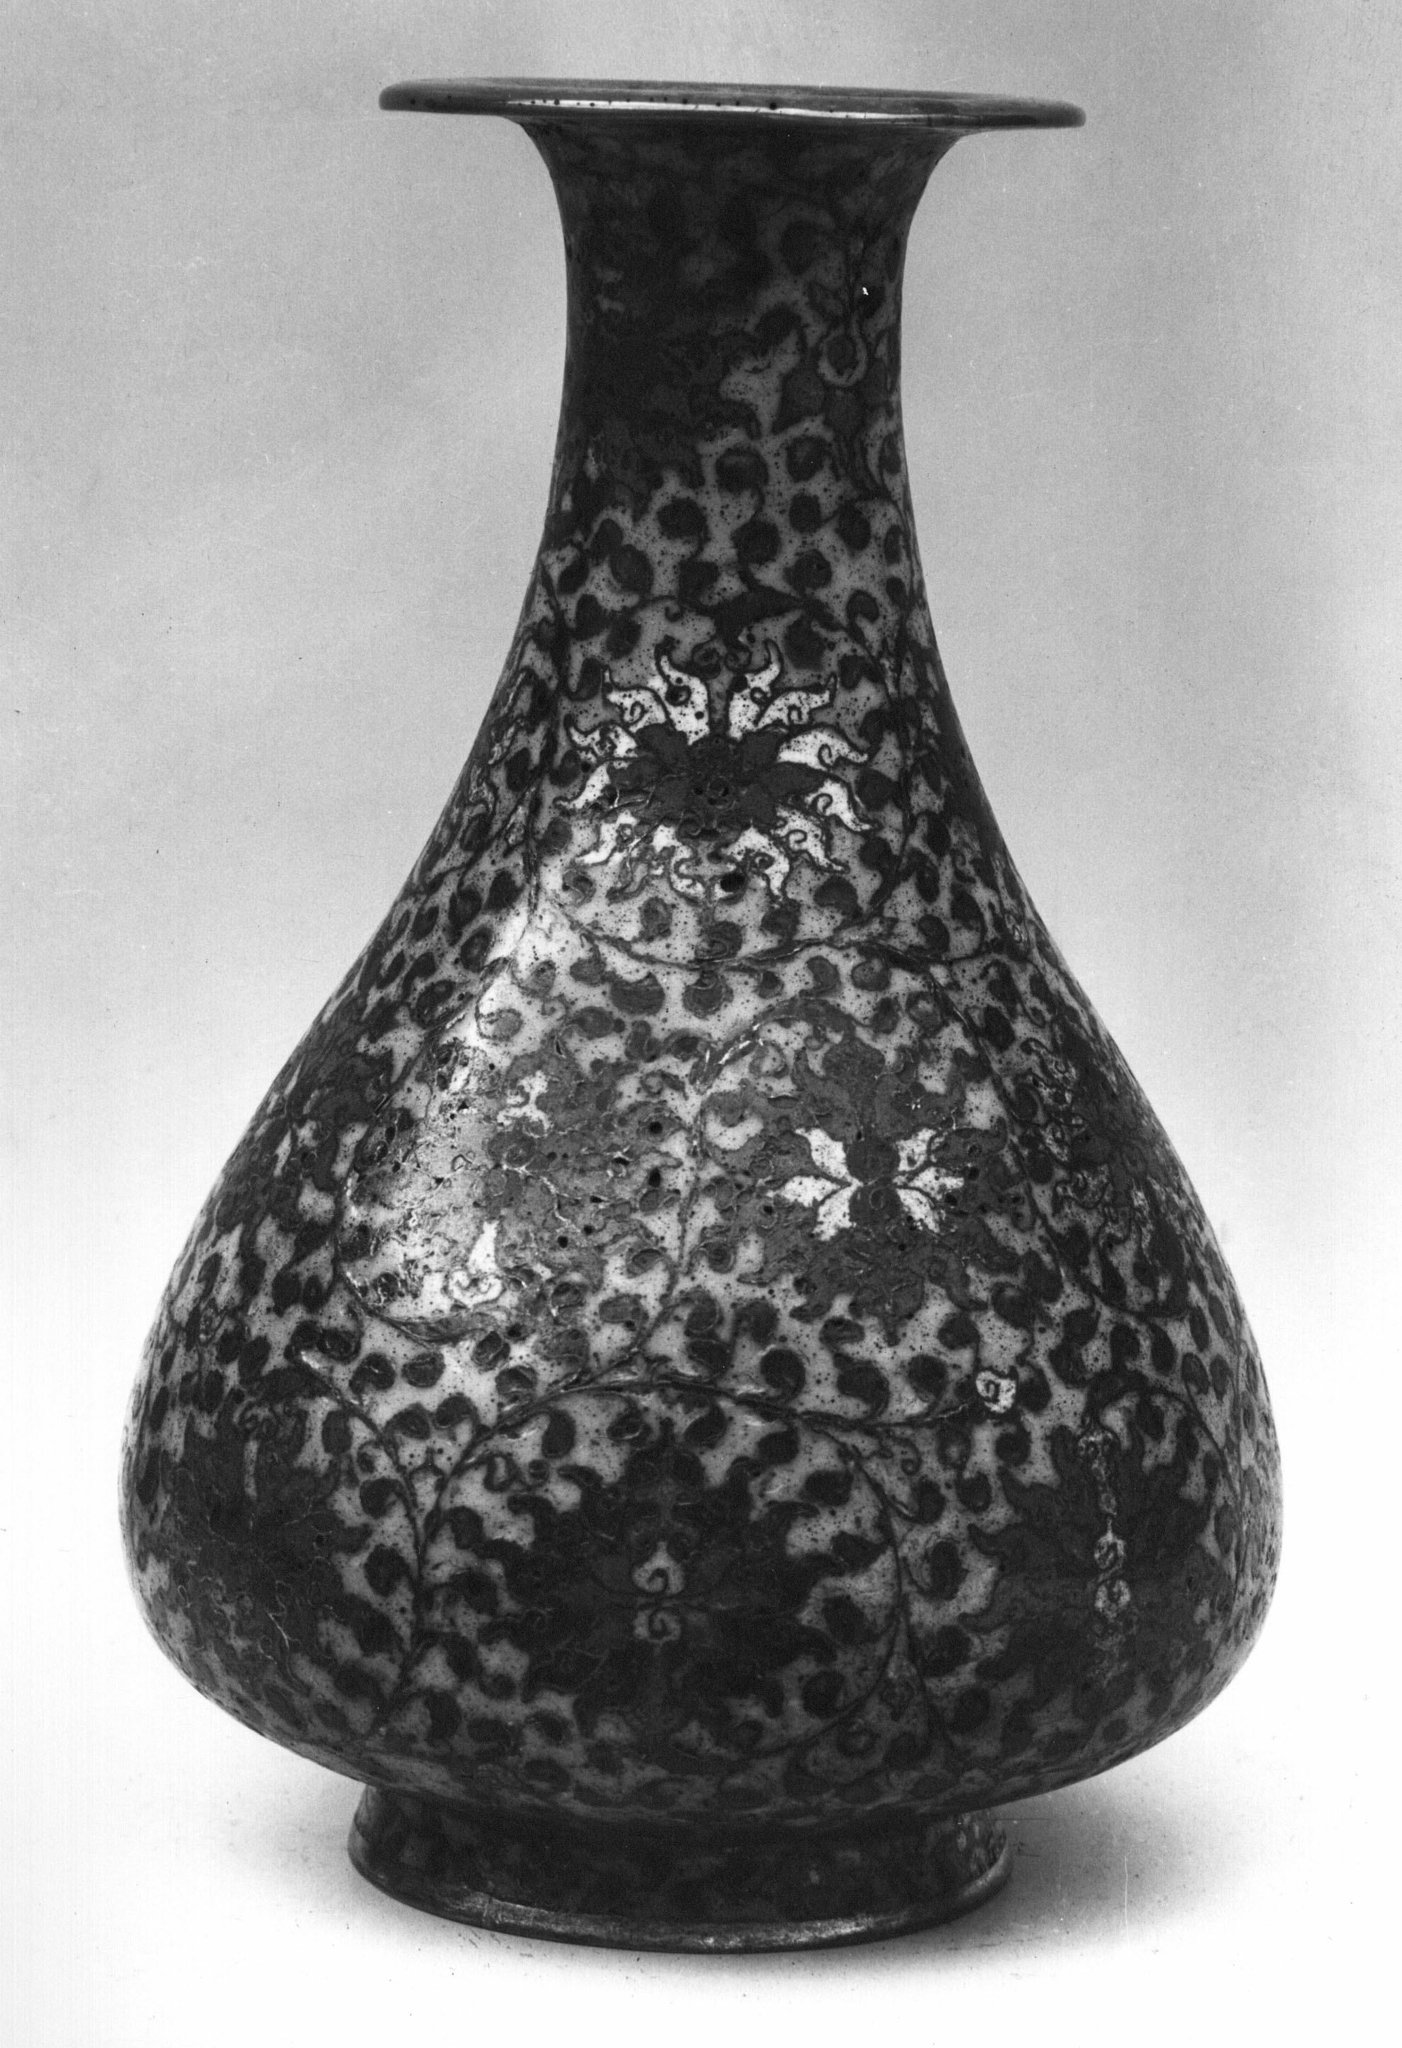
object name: vase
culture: chinese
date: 1368-1644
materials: copper, enamel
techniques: enamel